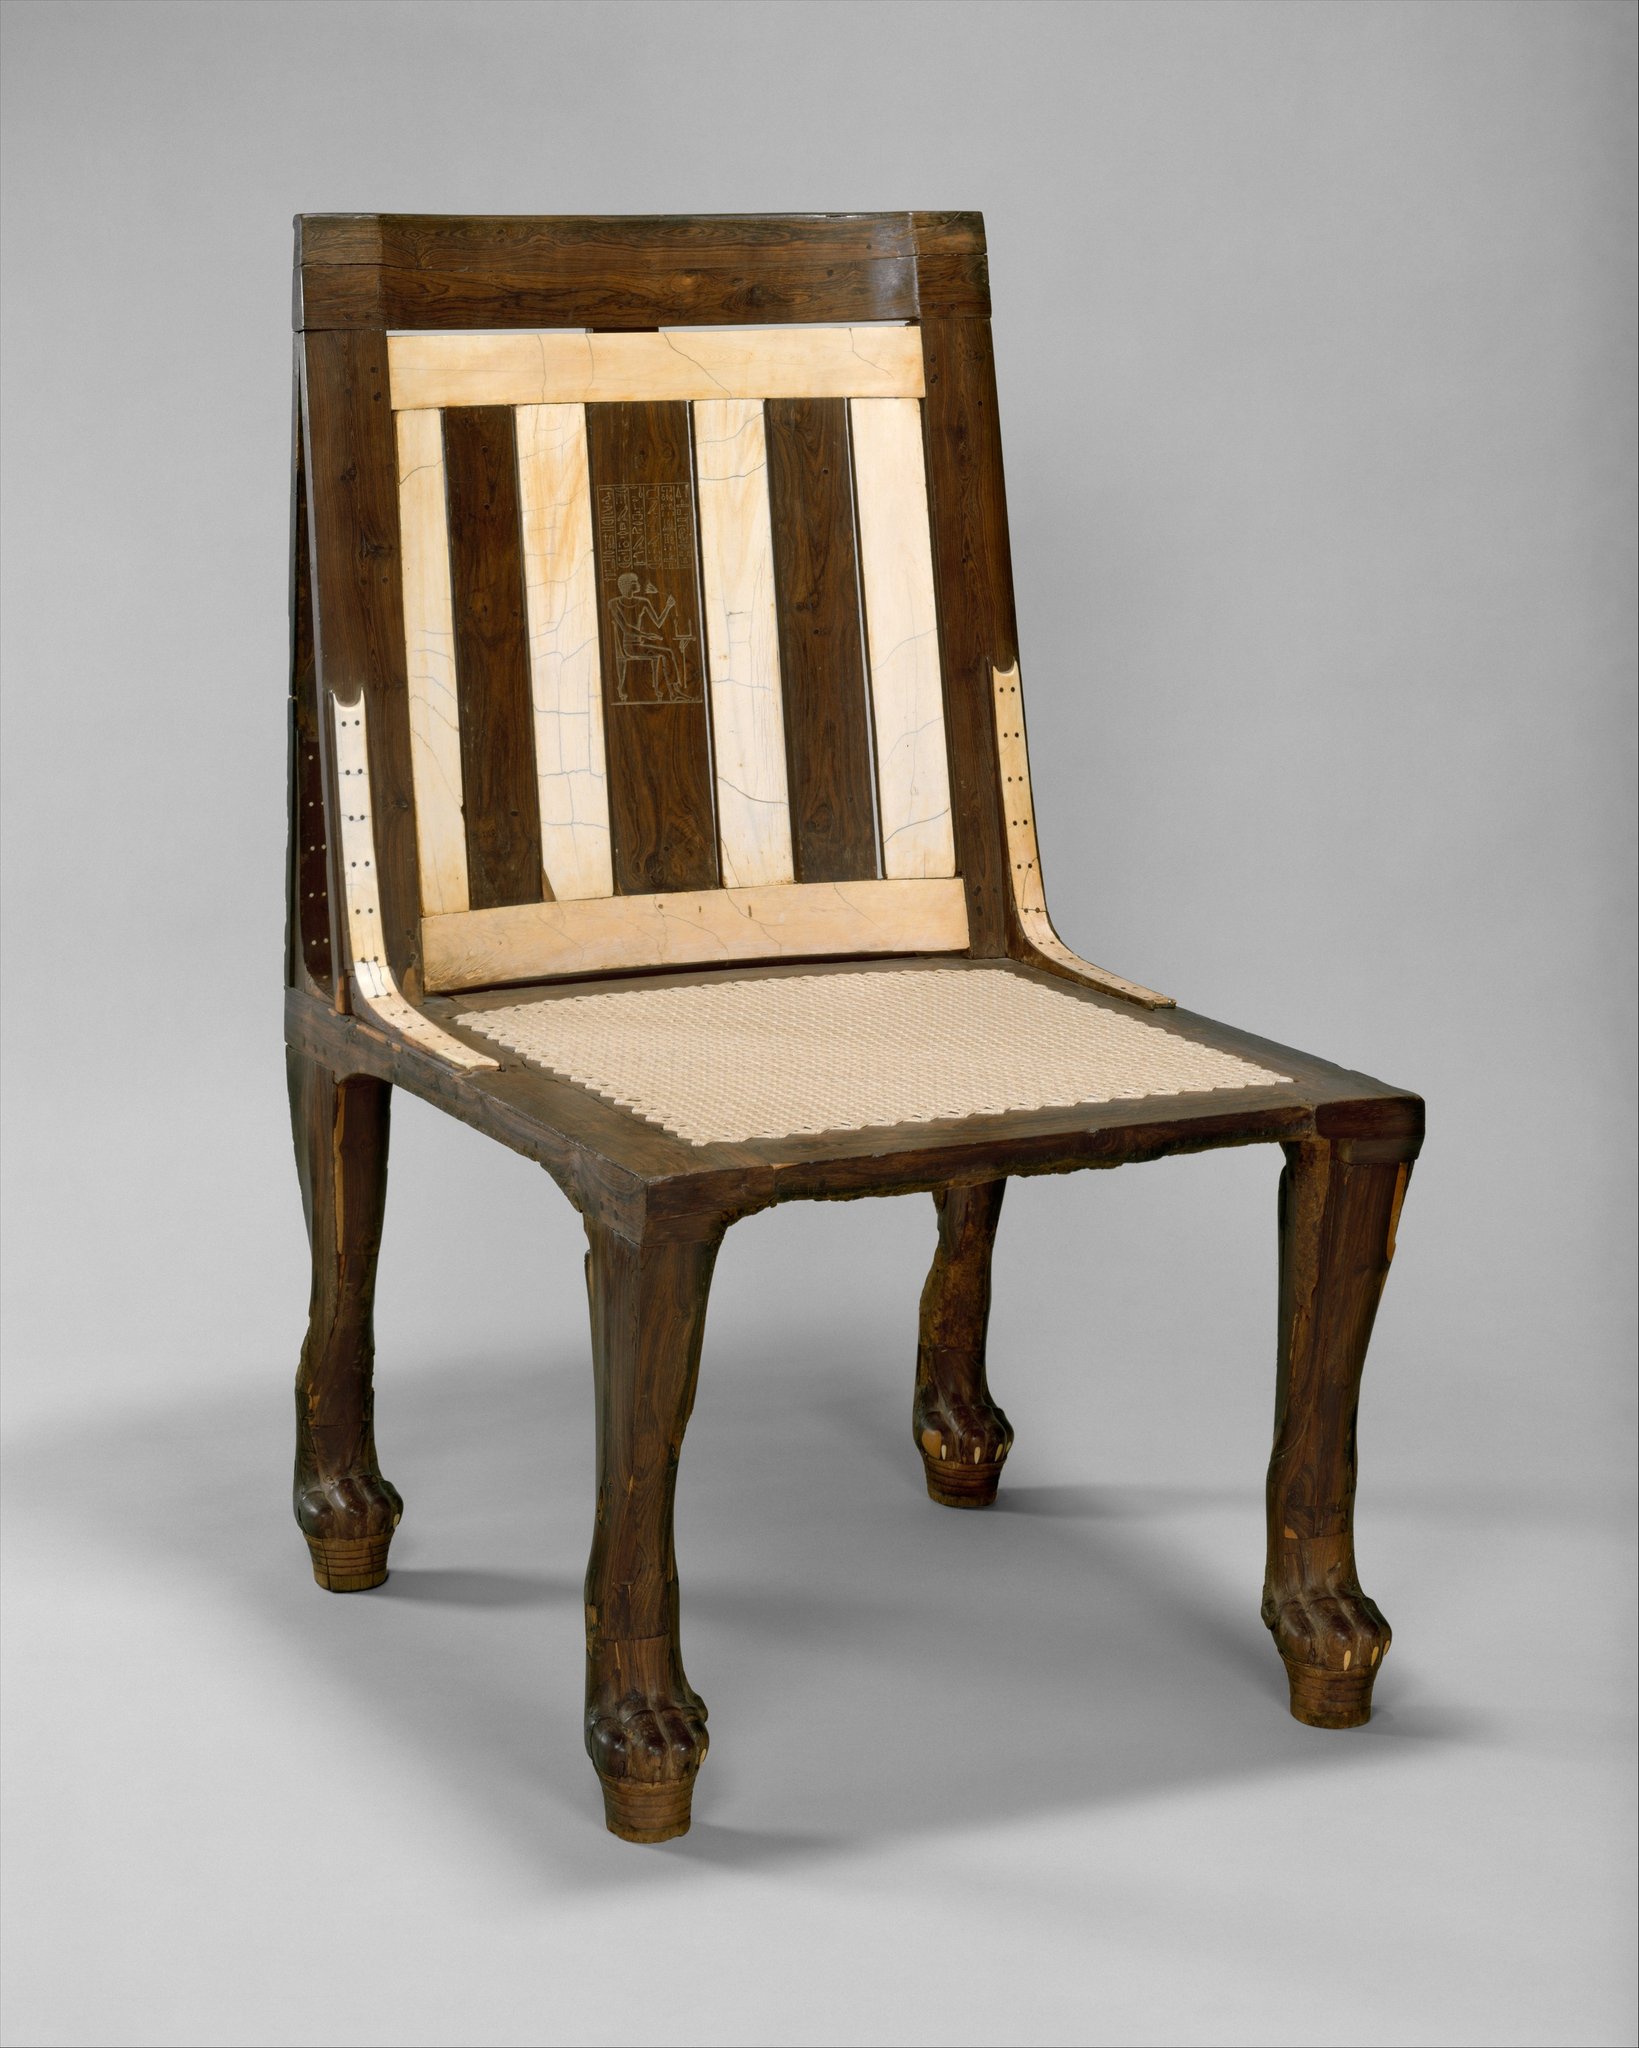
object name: chair, reniseneb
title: Chair of Reniseneb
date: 1450 BCE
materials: wood, ivory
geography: egypt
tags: men,hieroglyphs